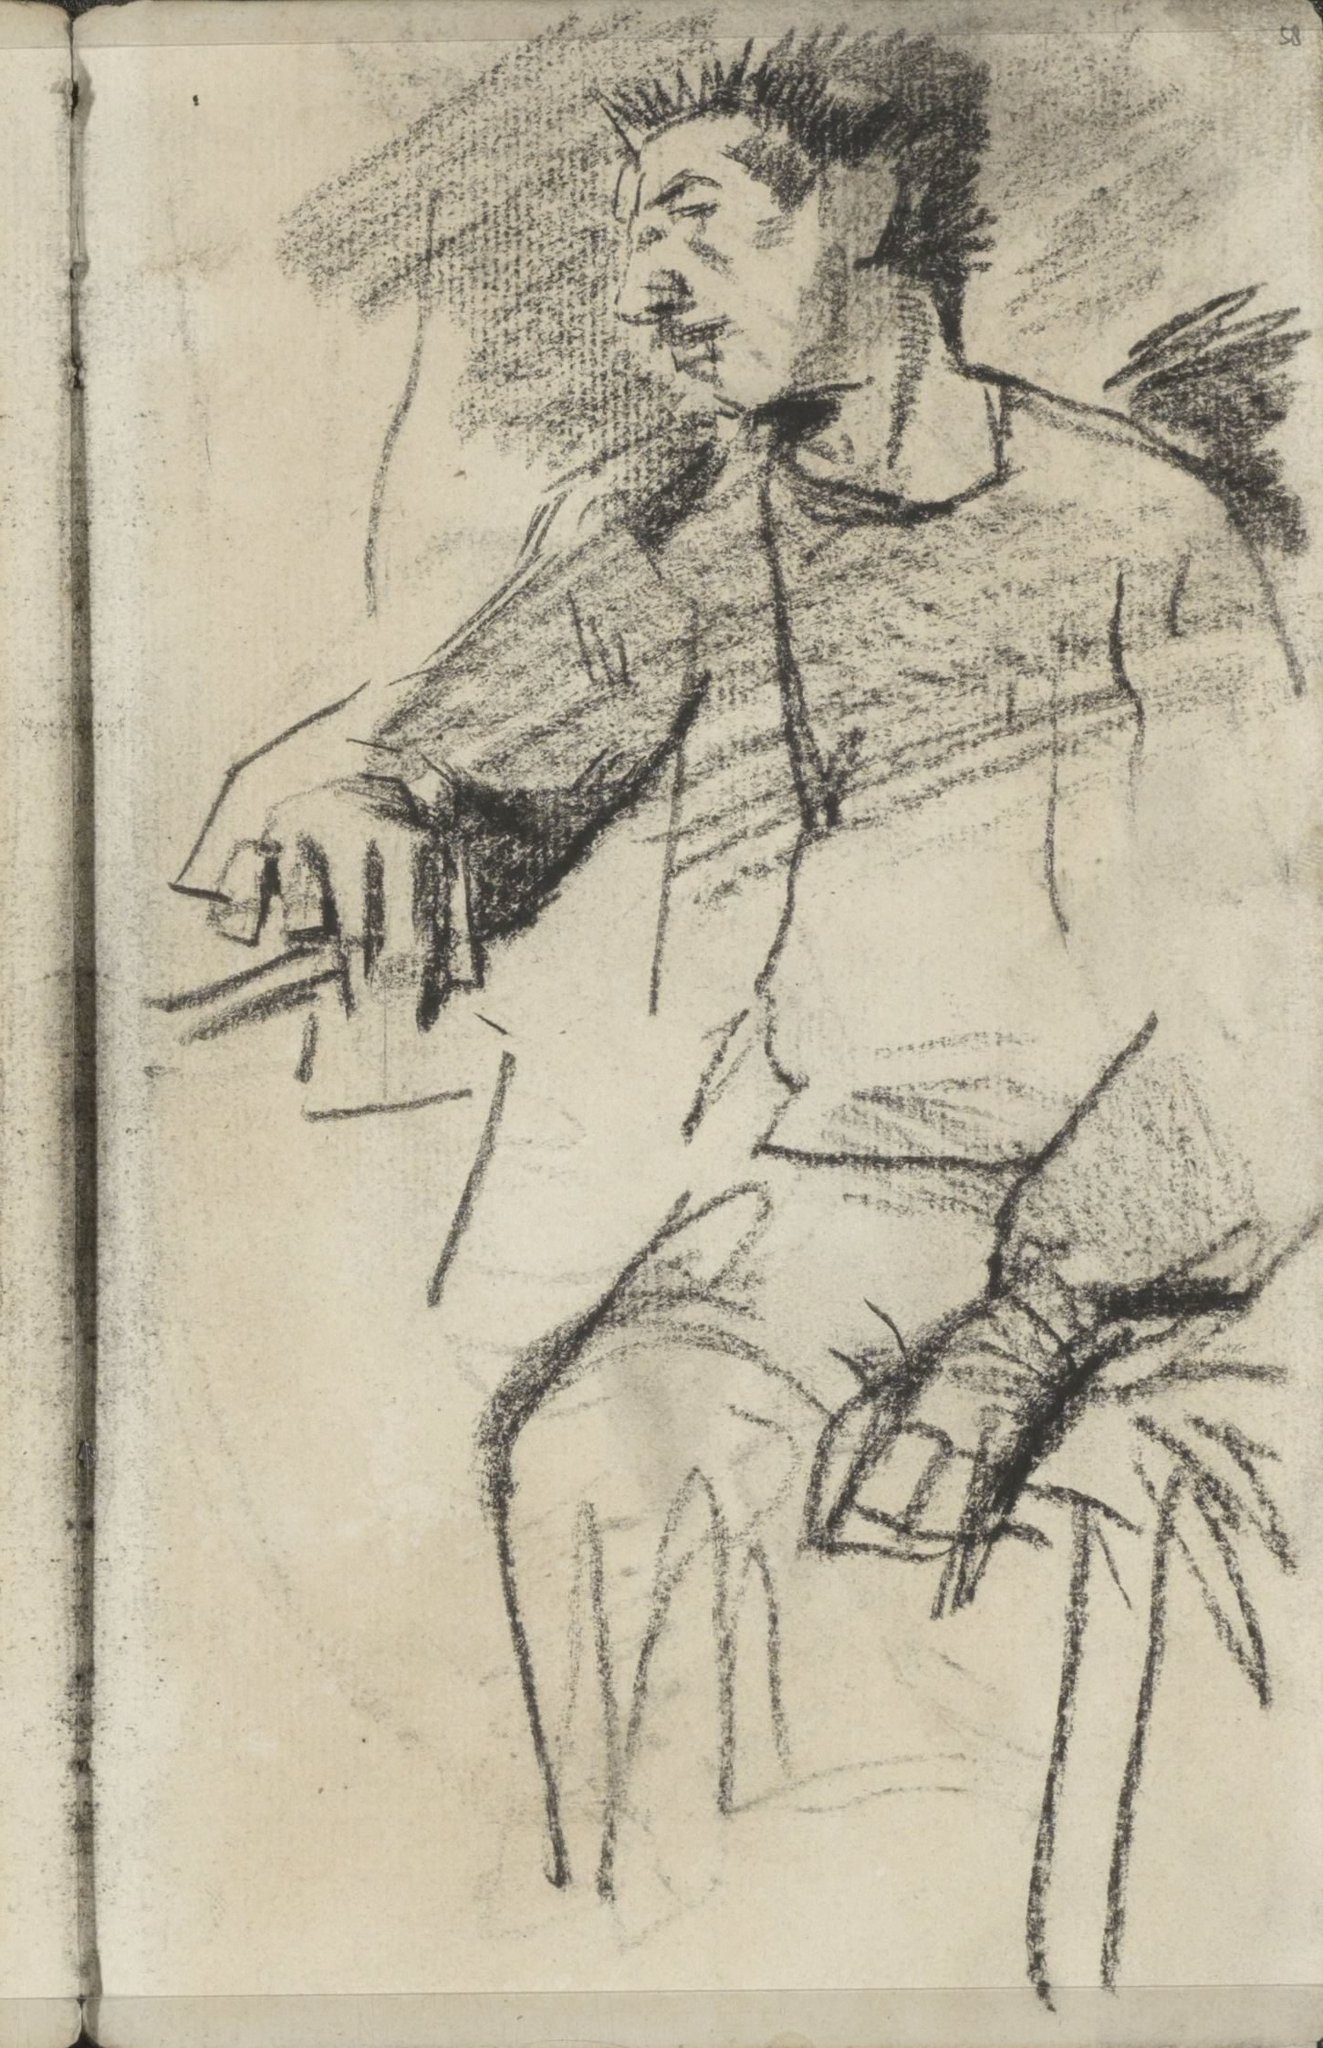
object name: sketchbook leaf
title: Zittende man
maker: george hendrik breitner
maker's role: draughtsman, painter, print maker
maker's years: 1857-1923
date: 1884-1886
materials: chalk, paper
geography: the hague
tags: sitting figure, adult man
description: Pagina 58 uit een schetsboek met 29 bladen.